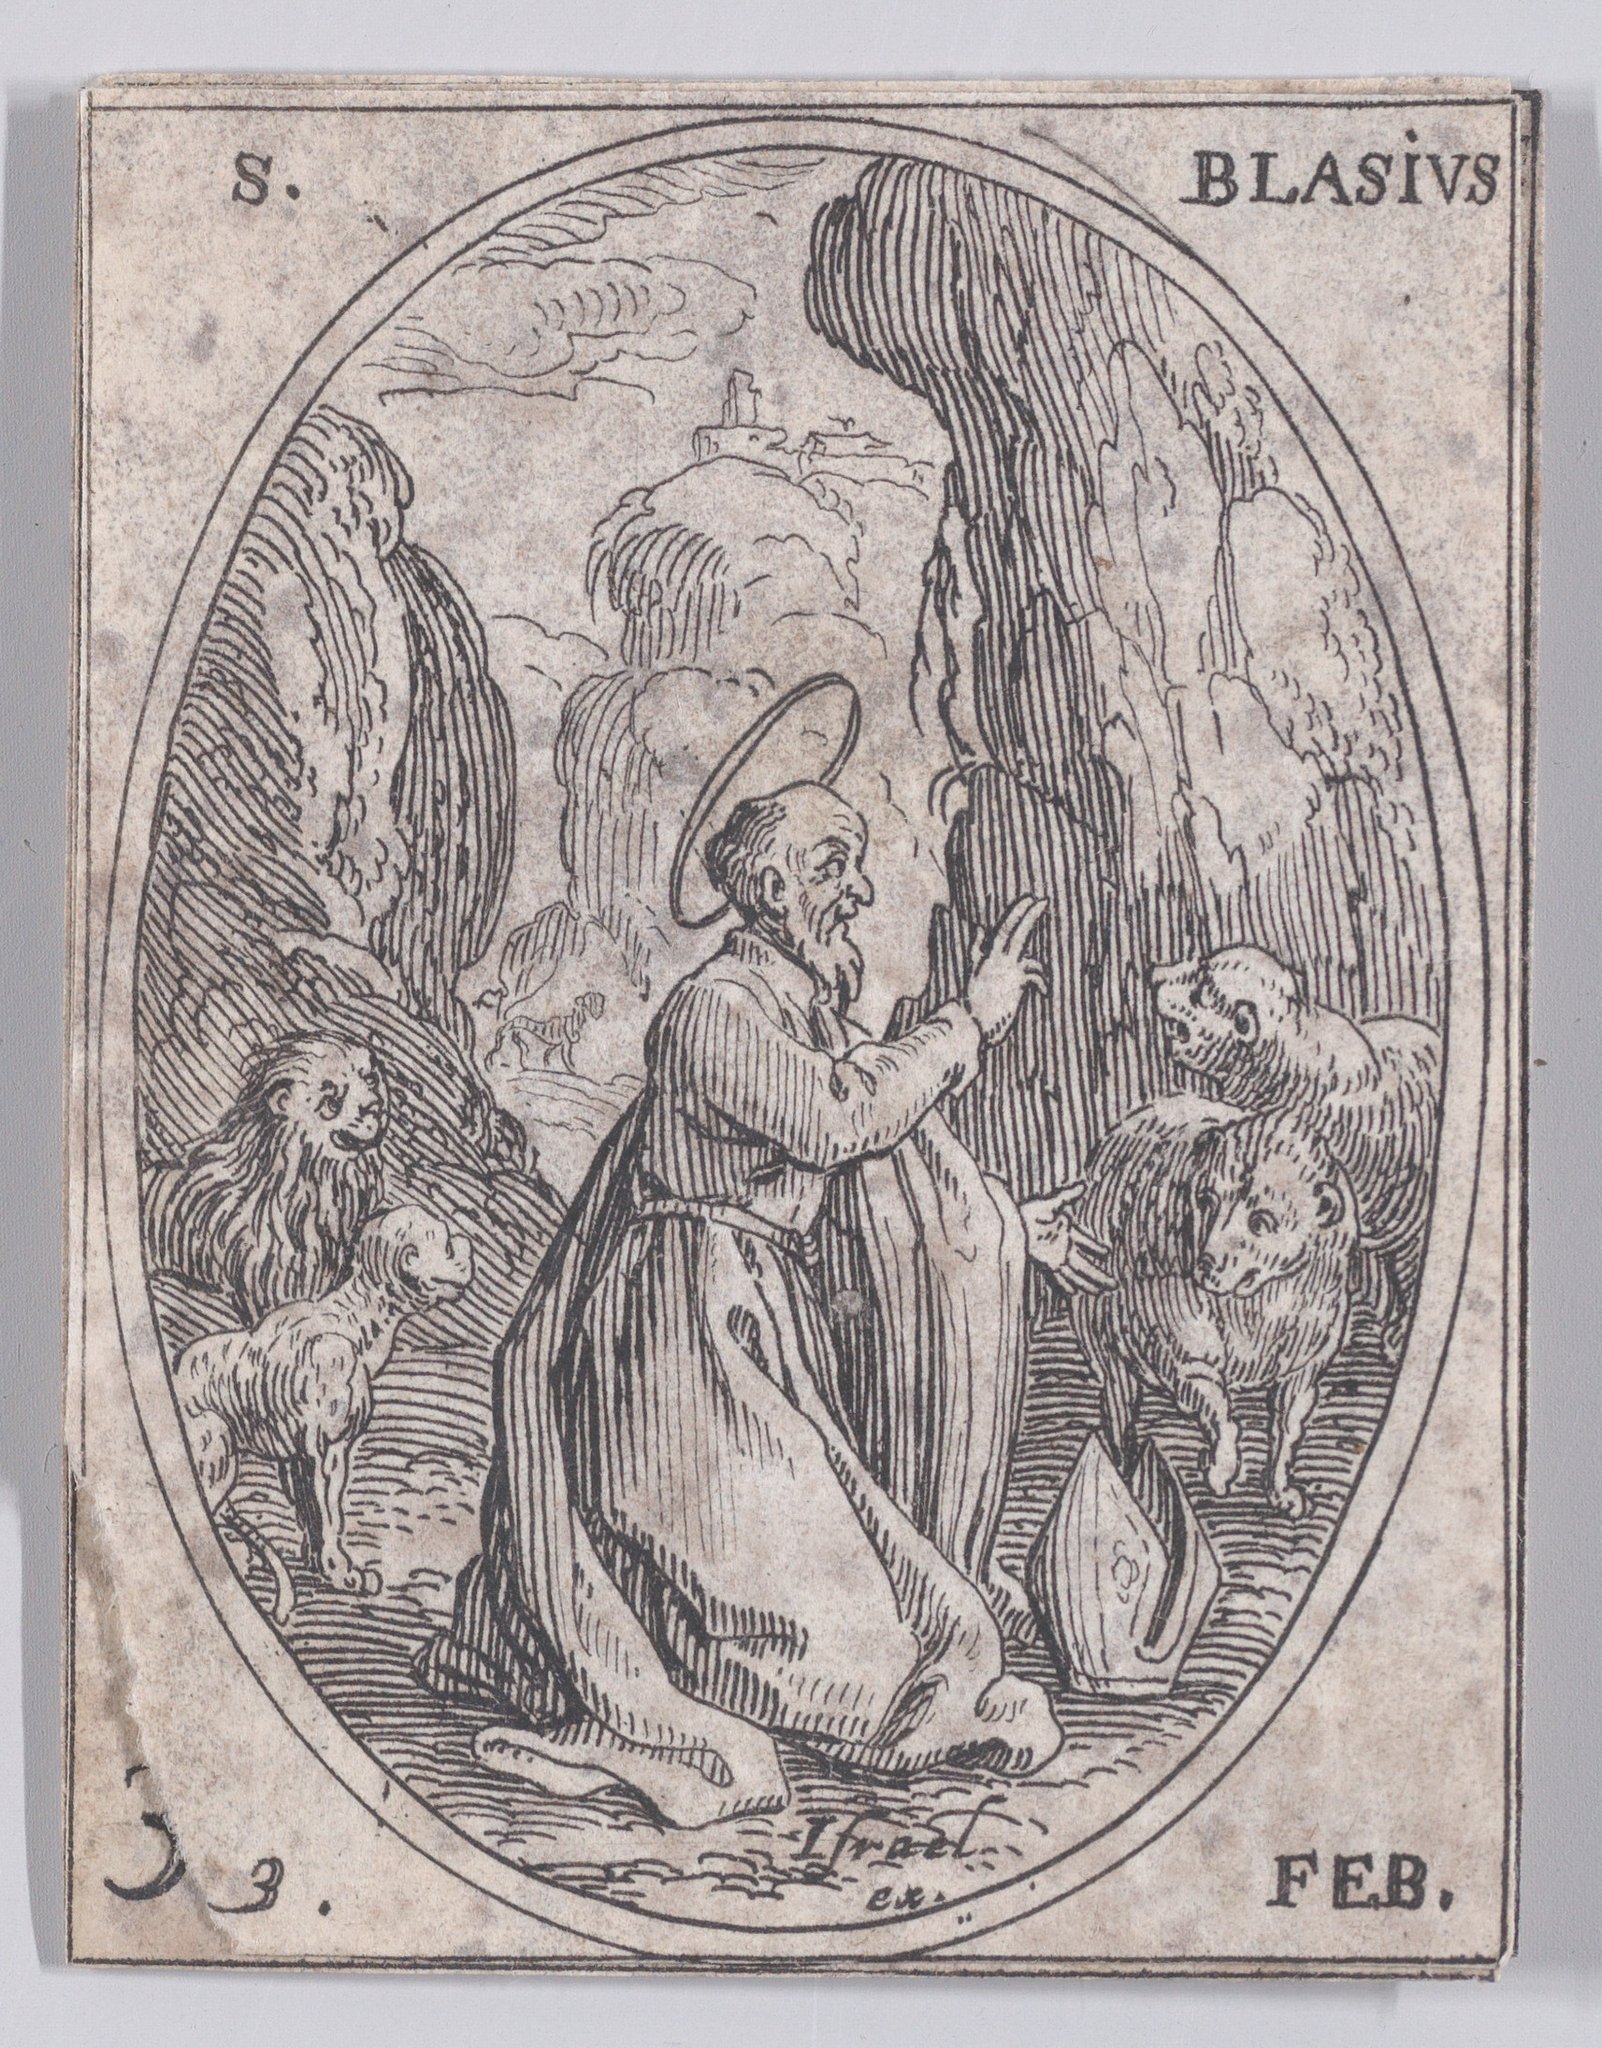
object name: print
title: St. Blaise, February 3rd, from "Les Images De Tous Les Saincts et Saintes de L'Année" (Images of All of the Saints and Feast Days of the Year)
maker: jacques callot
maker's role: artist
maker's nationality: french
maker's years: 1592-1635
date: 1636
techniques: etching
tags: animals,men,saints